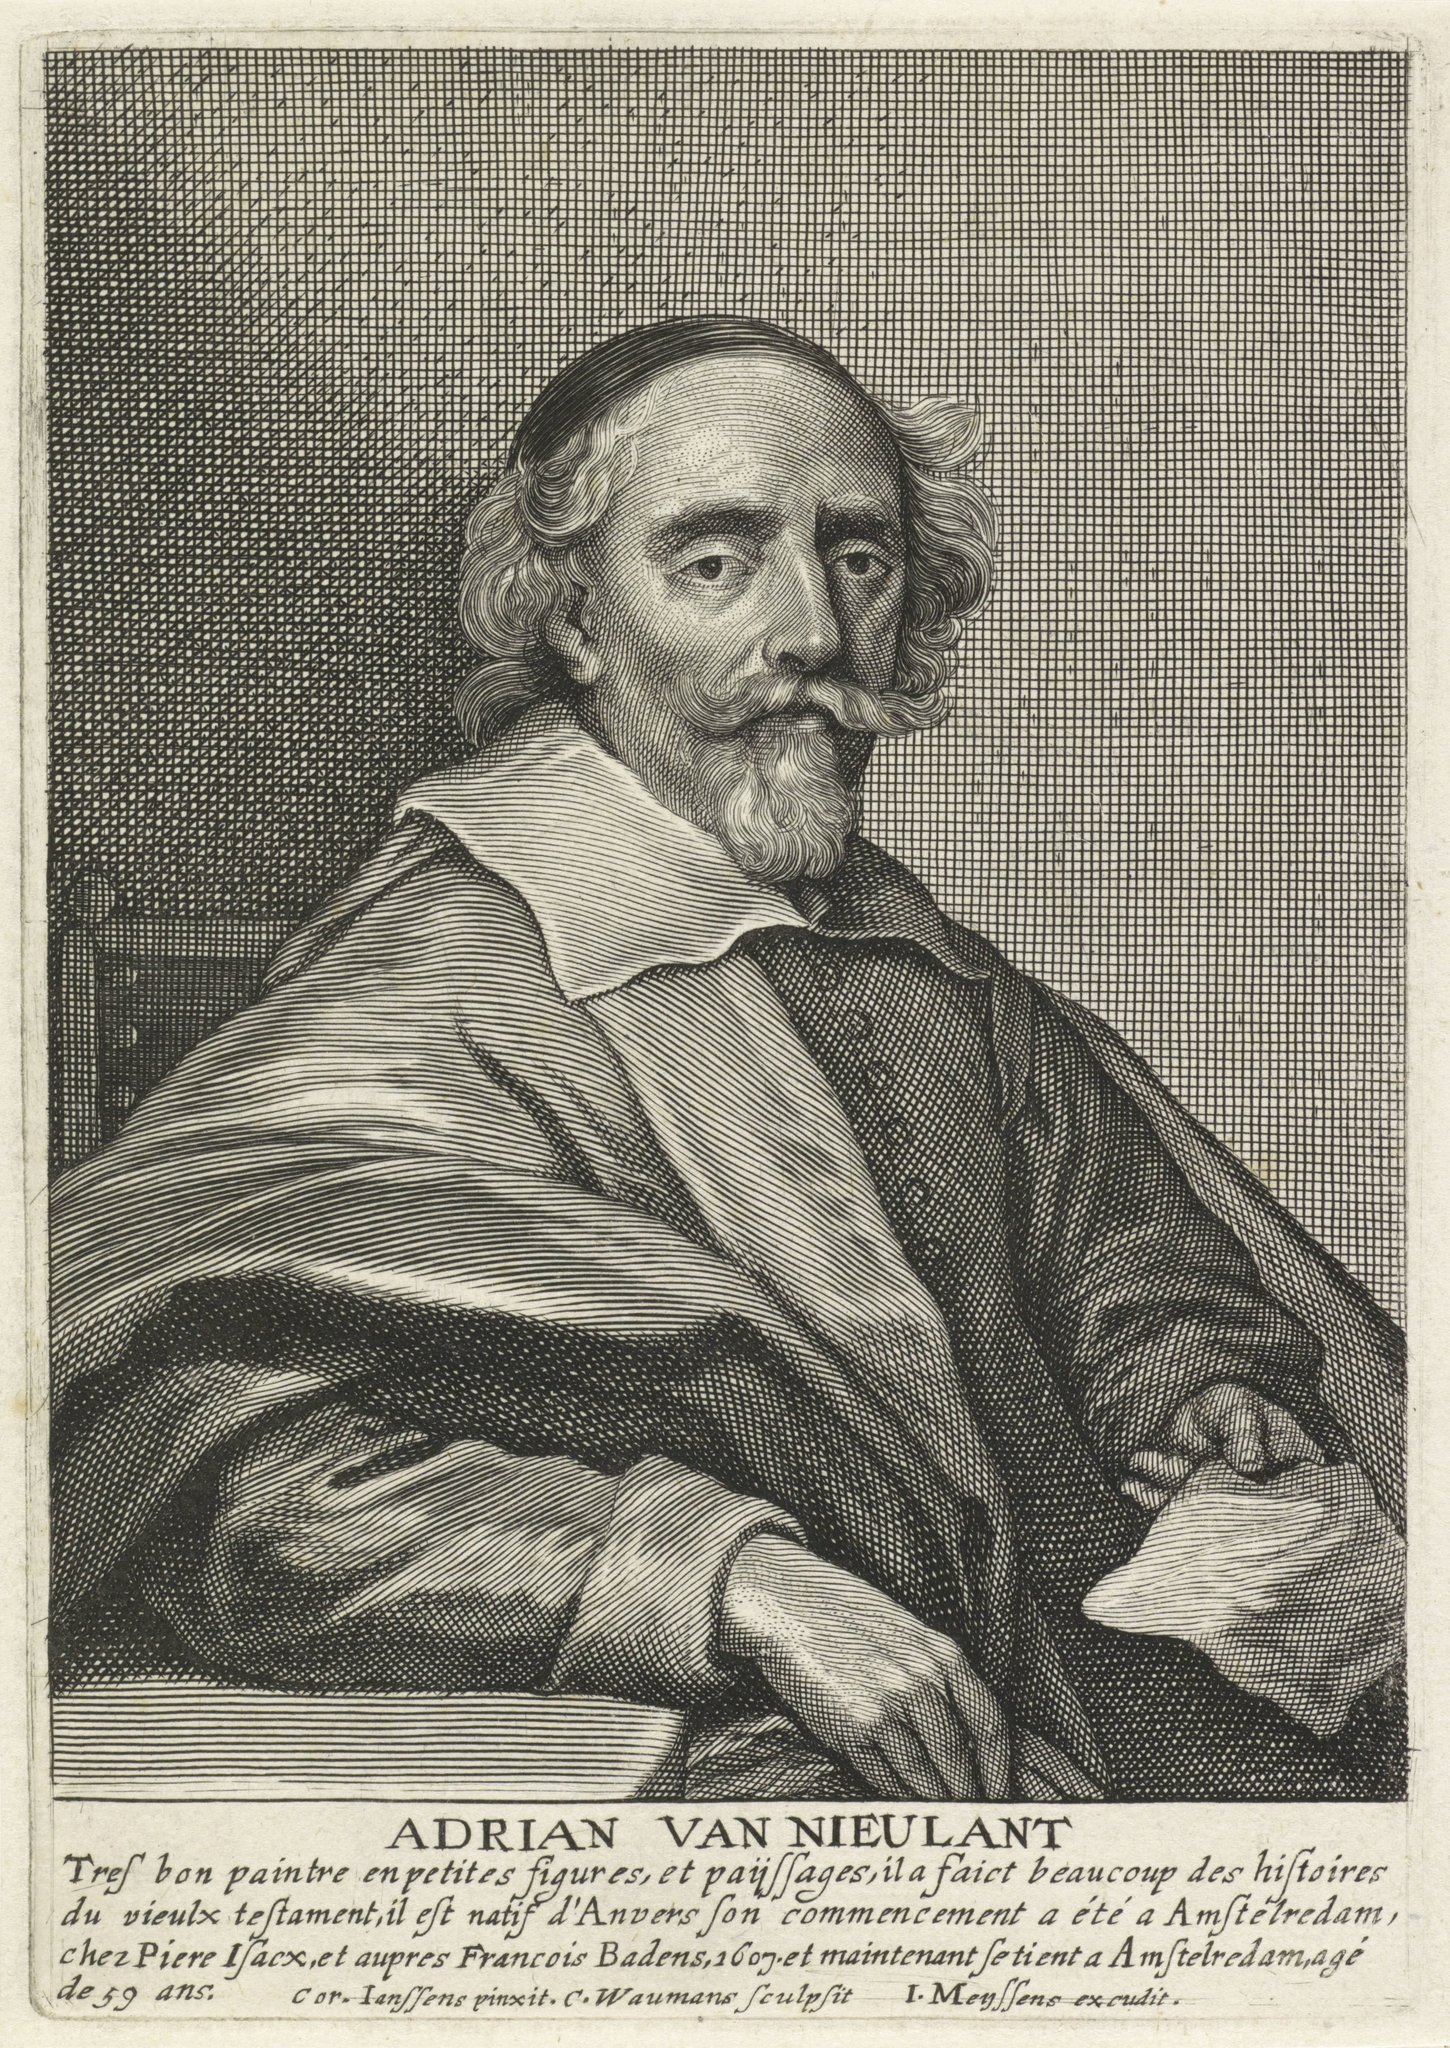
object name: print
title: Portret van de schilder Adriaen van Nieulandt (I)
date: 1649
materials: paper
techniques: engraving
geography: antwerp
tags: antwerp, amsterdam, painter, draughtsman, adriaen van nieulandt (i), portrait, self-portrait of painter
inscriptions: collector's mark: Lugt 2228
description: Prent gebruikt in: Image de divers hommes d'esprit sublime, qui par leur art et science devraient vivre éternellement et desquels la louange et renommée faict estonner le monde. Antwerpen: J. Meyssens, 1649.